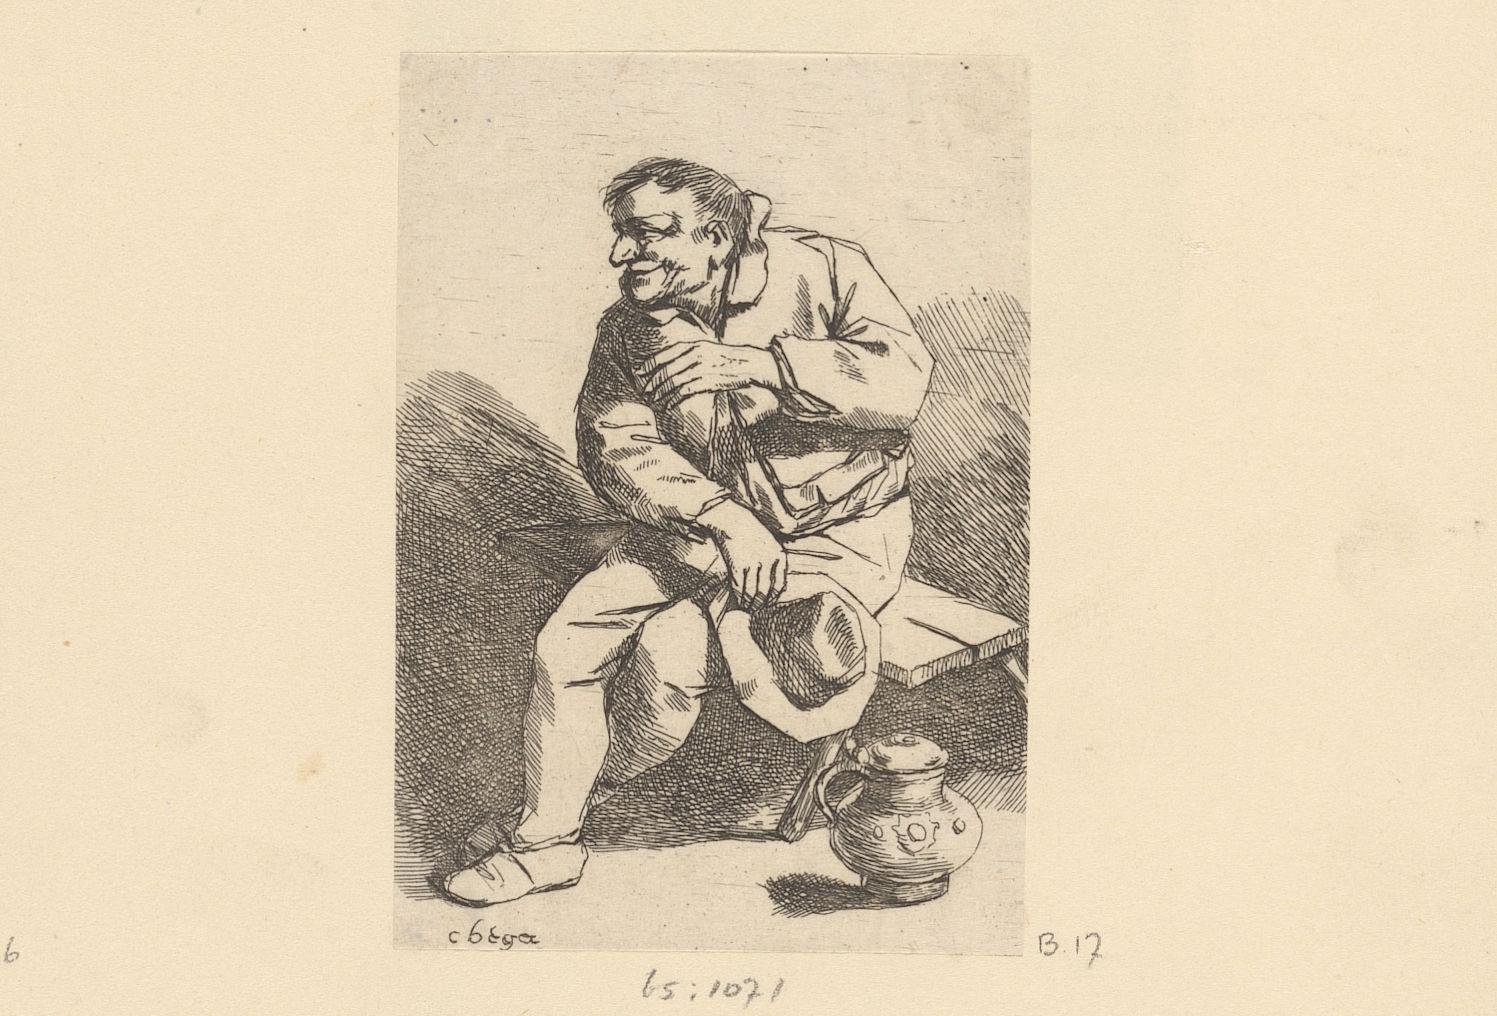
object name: album leaf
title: Zittende man met hoed en kan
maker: cornelis pietersz. bega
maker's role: draughtsman, painter, print maker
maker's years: 1631-1664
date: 1641-1664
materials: paper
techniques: etching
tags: head-gear, adult man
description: Prent maakt mogelijk deel uit van een serie van 200 prenten. Deze serie is onder de titel 'A Collection of two hundred original etchings' voor het eerst uitgegeven door J.M. Greery in 1816.